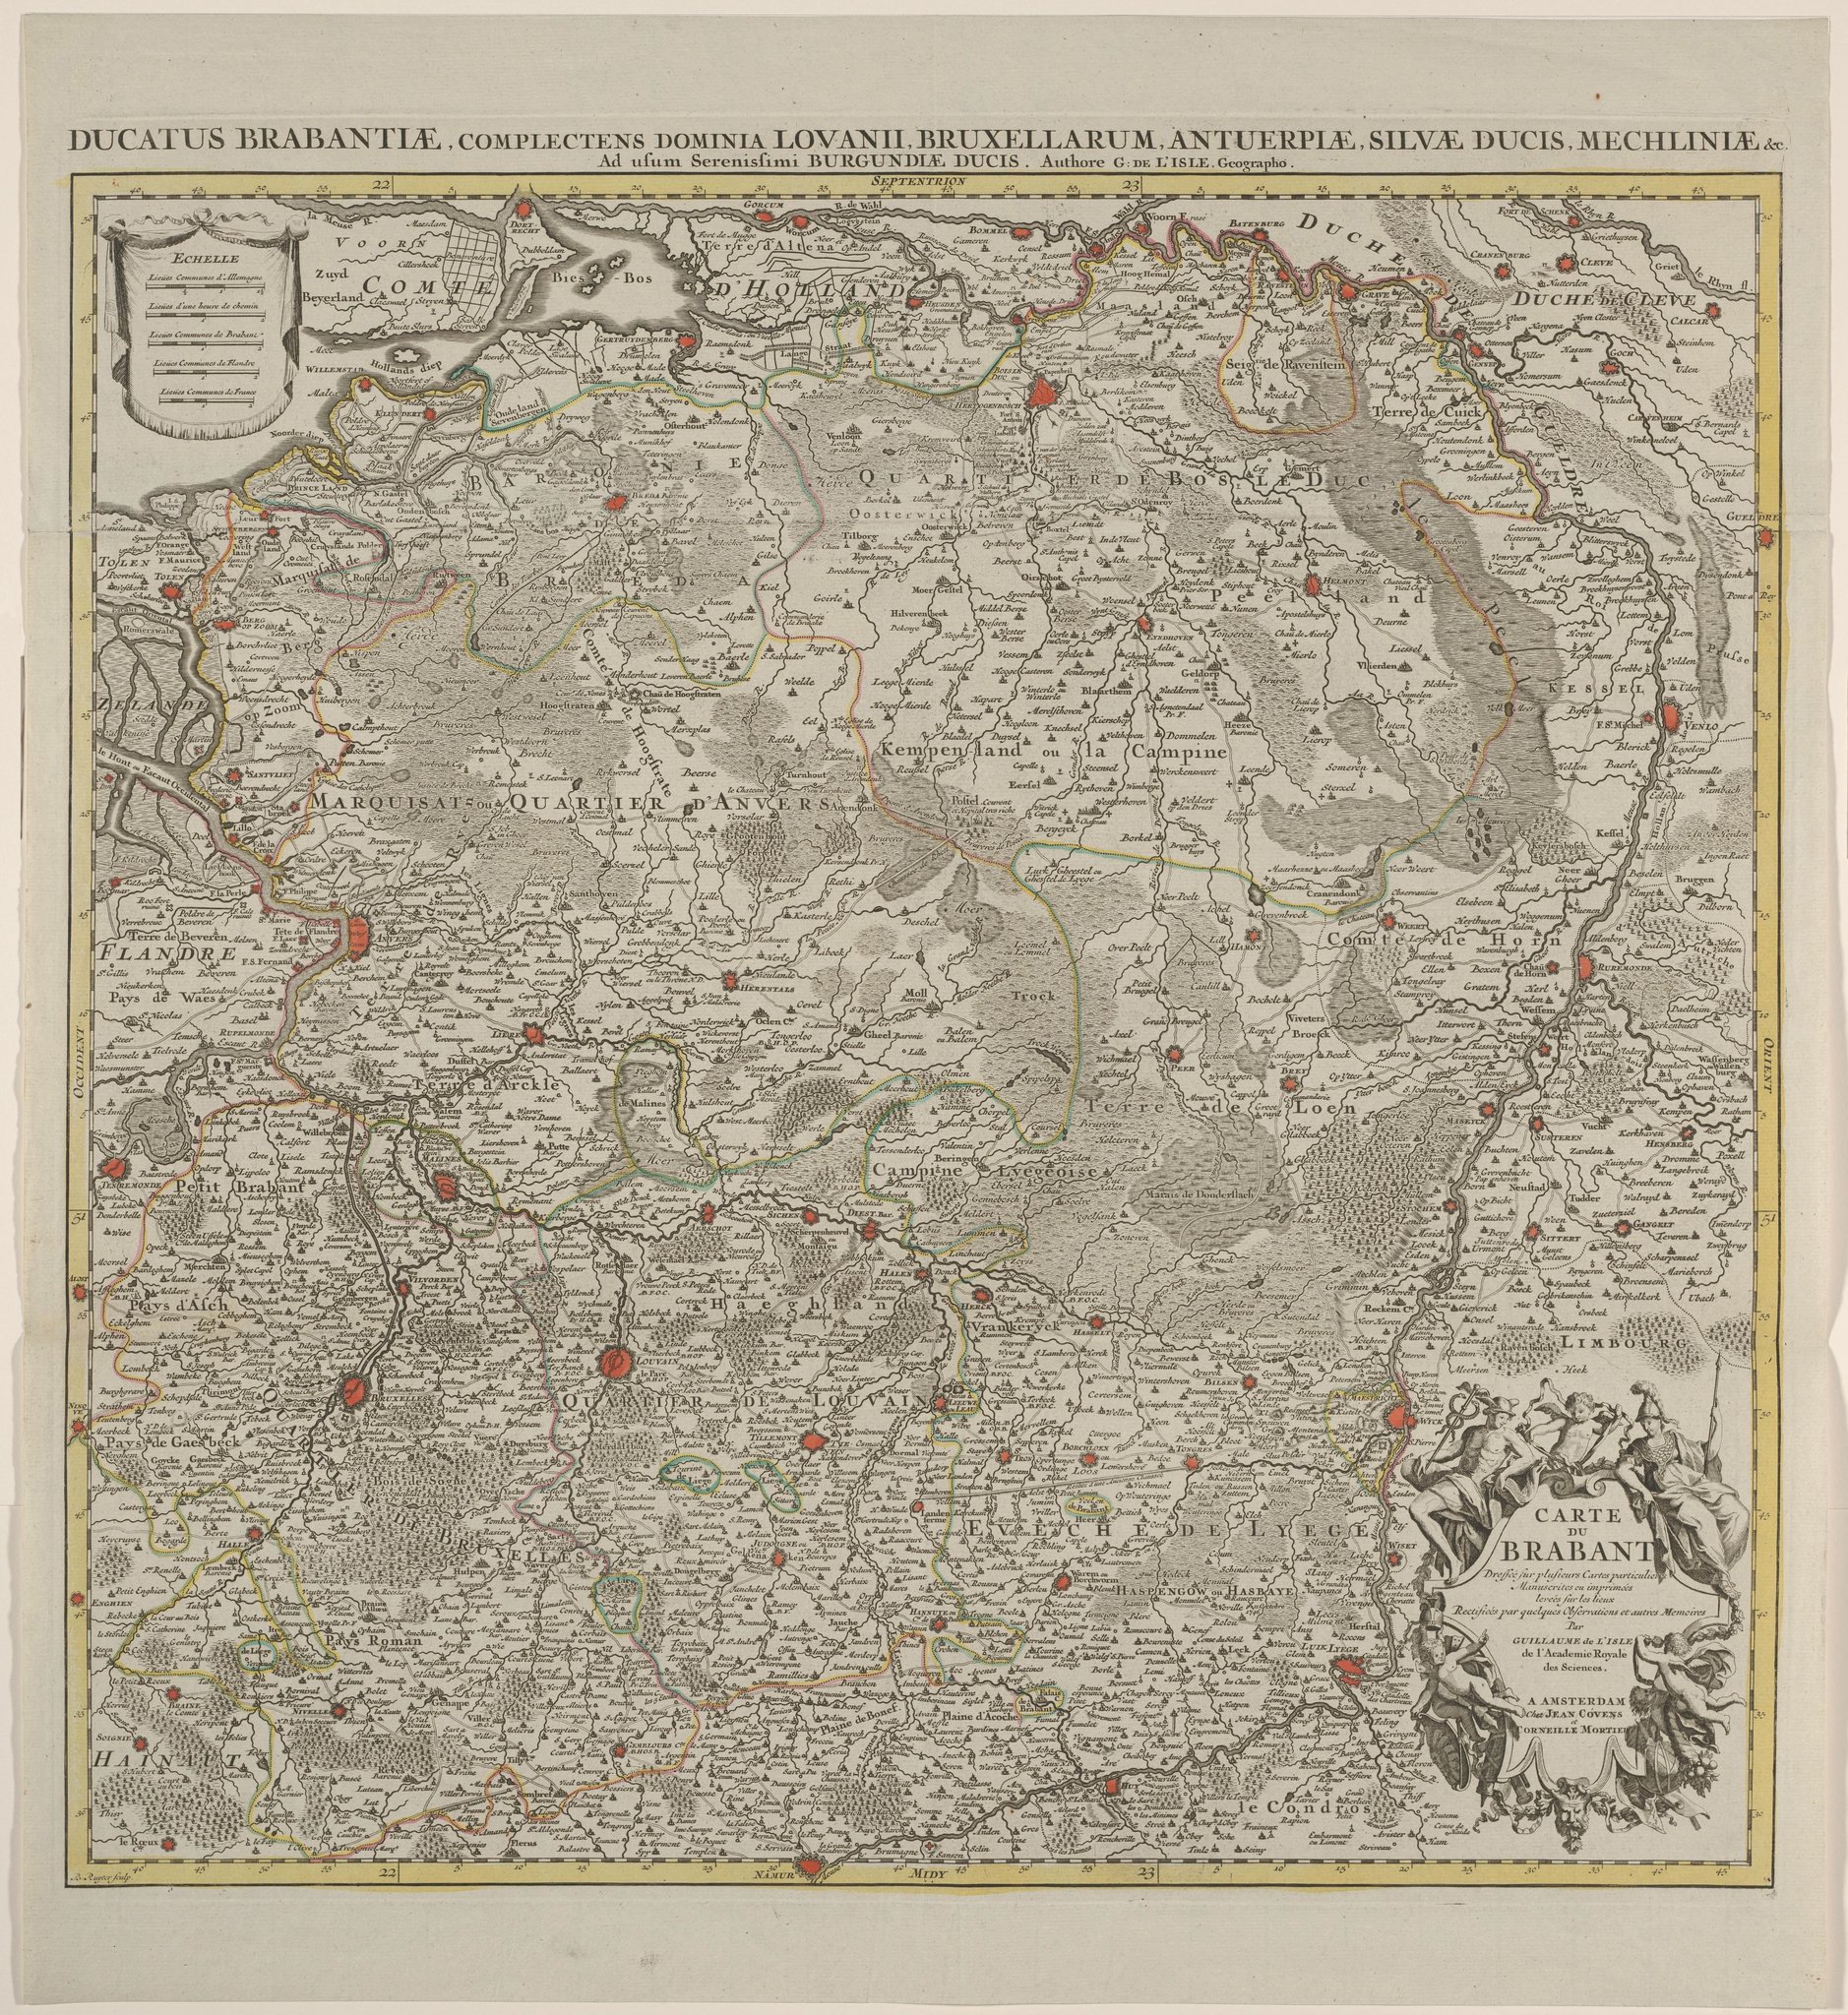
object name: map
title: Ducatus Brabantiae, complectens dominia Lovanii, Bruxellarum (...) / Carte du Brabant dressée sur plusieurs cartes particulieres (...)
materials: paper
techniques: engraving, etching, hand coloring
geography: amsterdam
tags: maps of separate countries or regions, (story of) minerva (pallas, athena), (story of) mercury (hermes), brabant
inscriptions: collector's mark: Lugt 2228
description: Kaart van Brabant. Rechtsonder de titelcartouche met Minerva, Mercurius en drie putti. Boven de kaart een tweede titel. Linksboven een cartouche met vijf schaalstokken: 1 1/2 Lieües Communes d'Allemagne / 2 Lieües d'une heure de chemin, en drie andere. De kaart is voorzien van een gradenverdeling langs de randen.